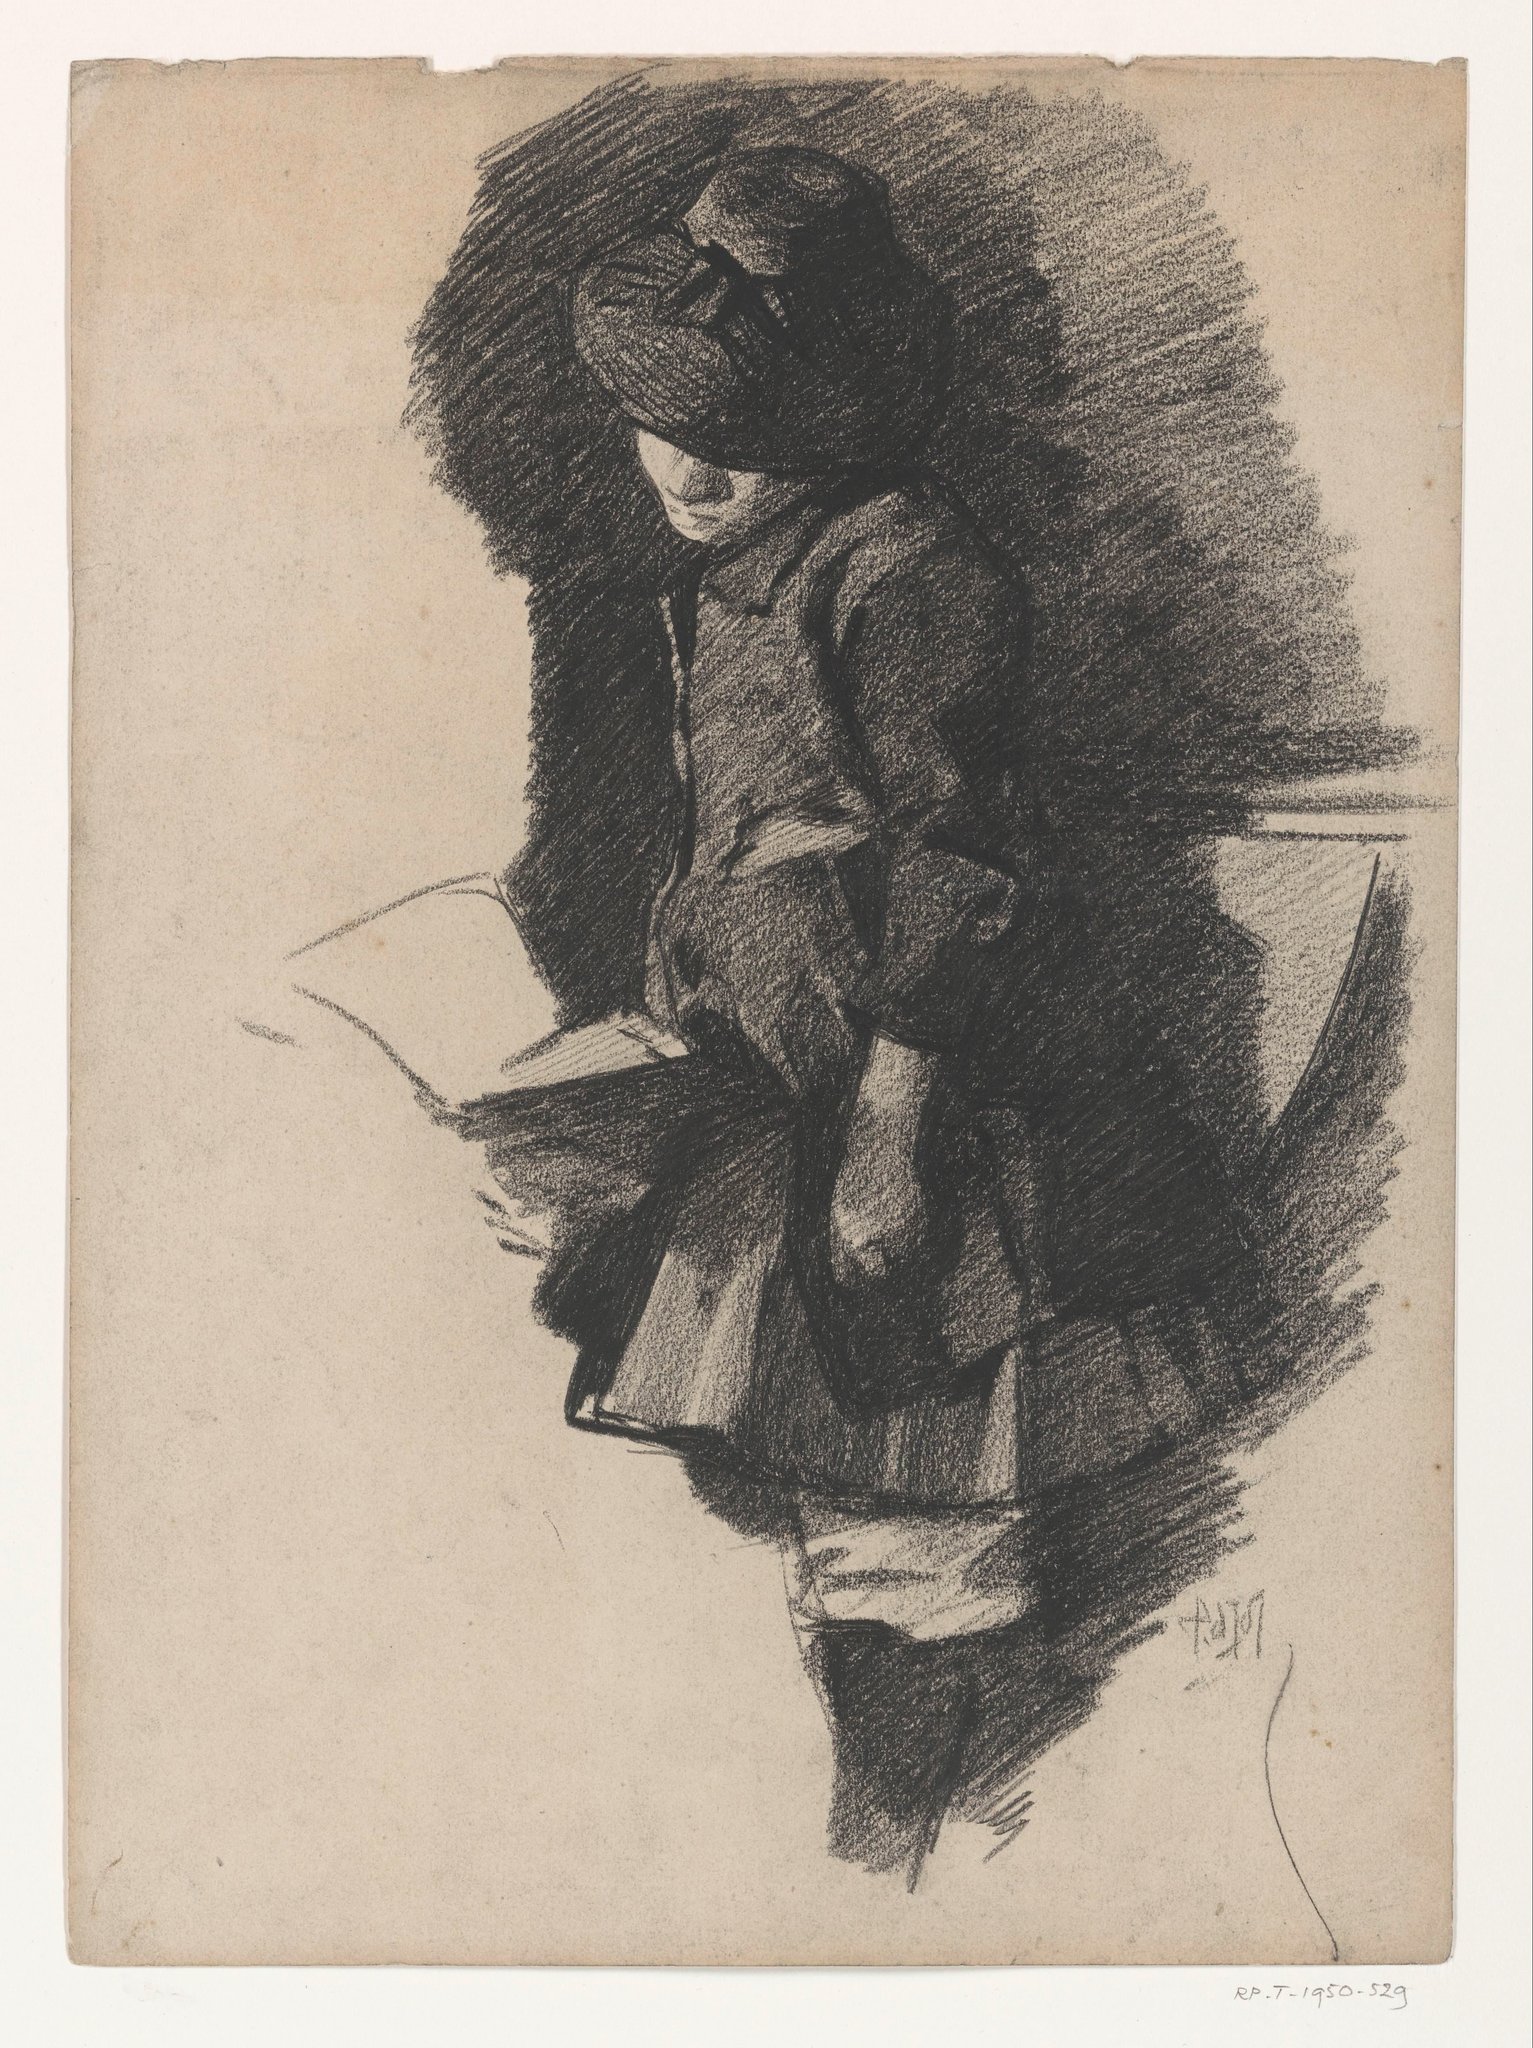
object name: drawing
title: Staand meisje met hoed, kijkend in een boek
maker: pieter de josselin de jong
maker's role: draughtsman, painter, print maker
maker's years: 1861-1906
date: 1871-1906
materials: chalk, paper